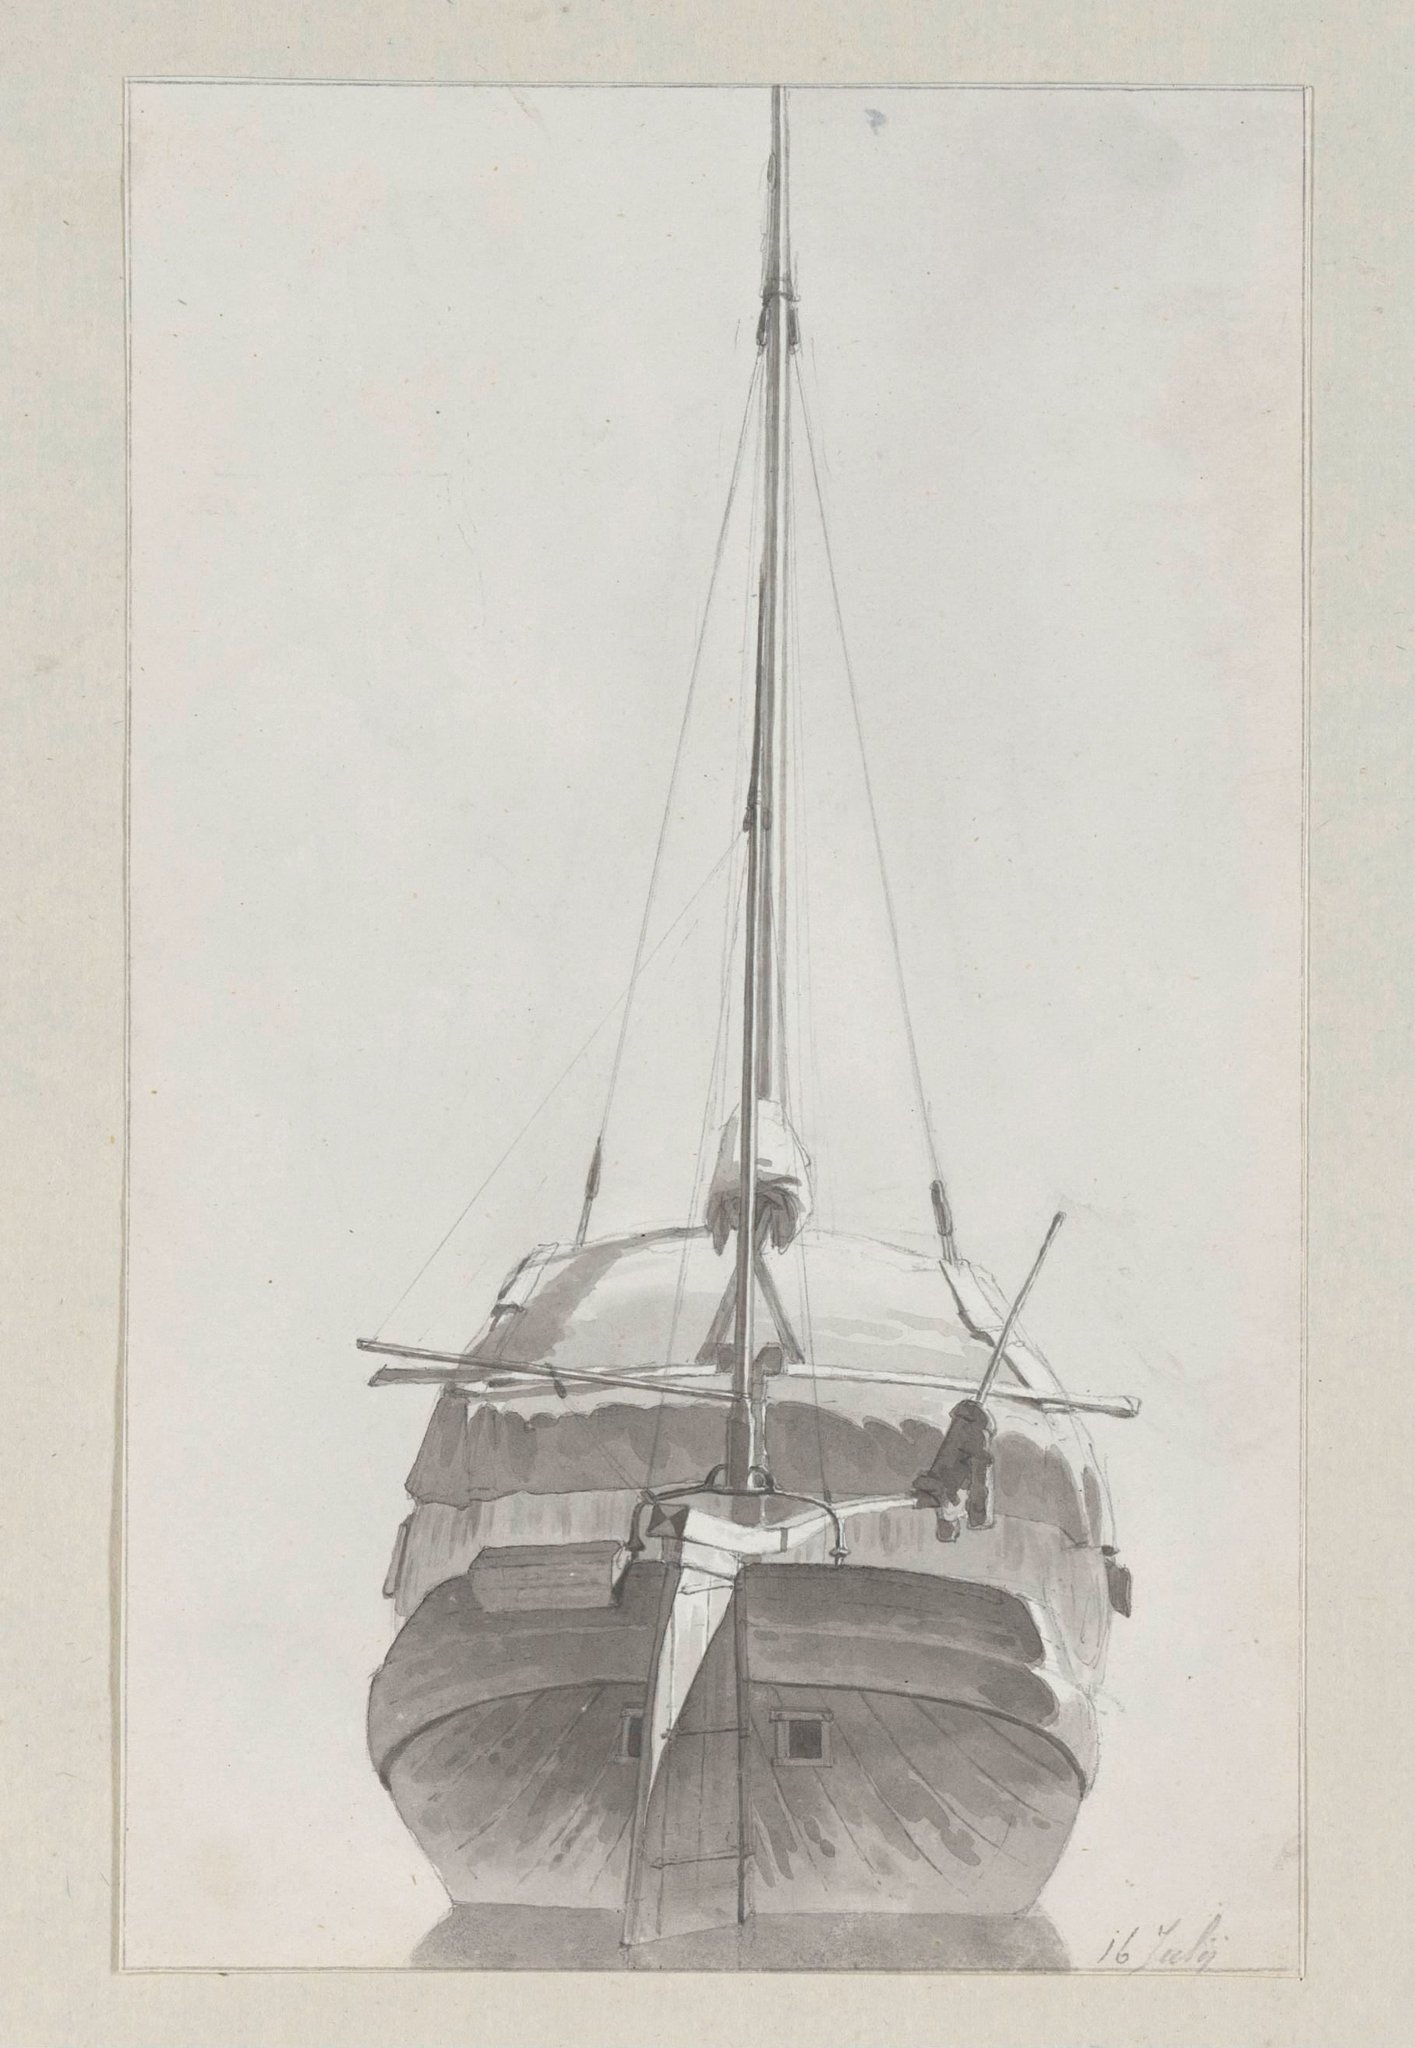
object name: drawing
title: Enkele zeilschepen, bij de wal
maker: hendrik abraham klinkhamer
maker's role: draughtsman, painter, print maker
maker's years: 1810-1872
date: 1820-1872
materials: paper, pencil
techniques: brush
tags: sailing-ship, sailing-boat